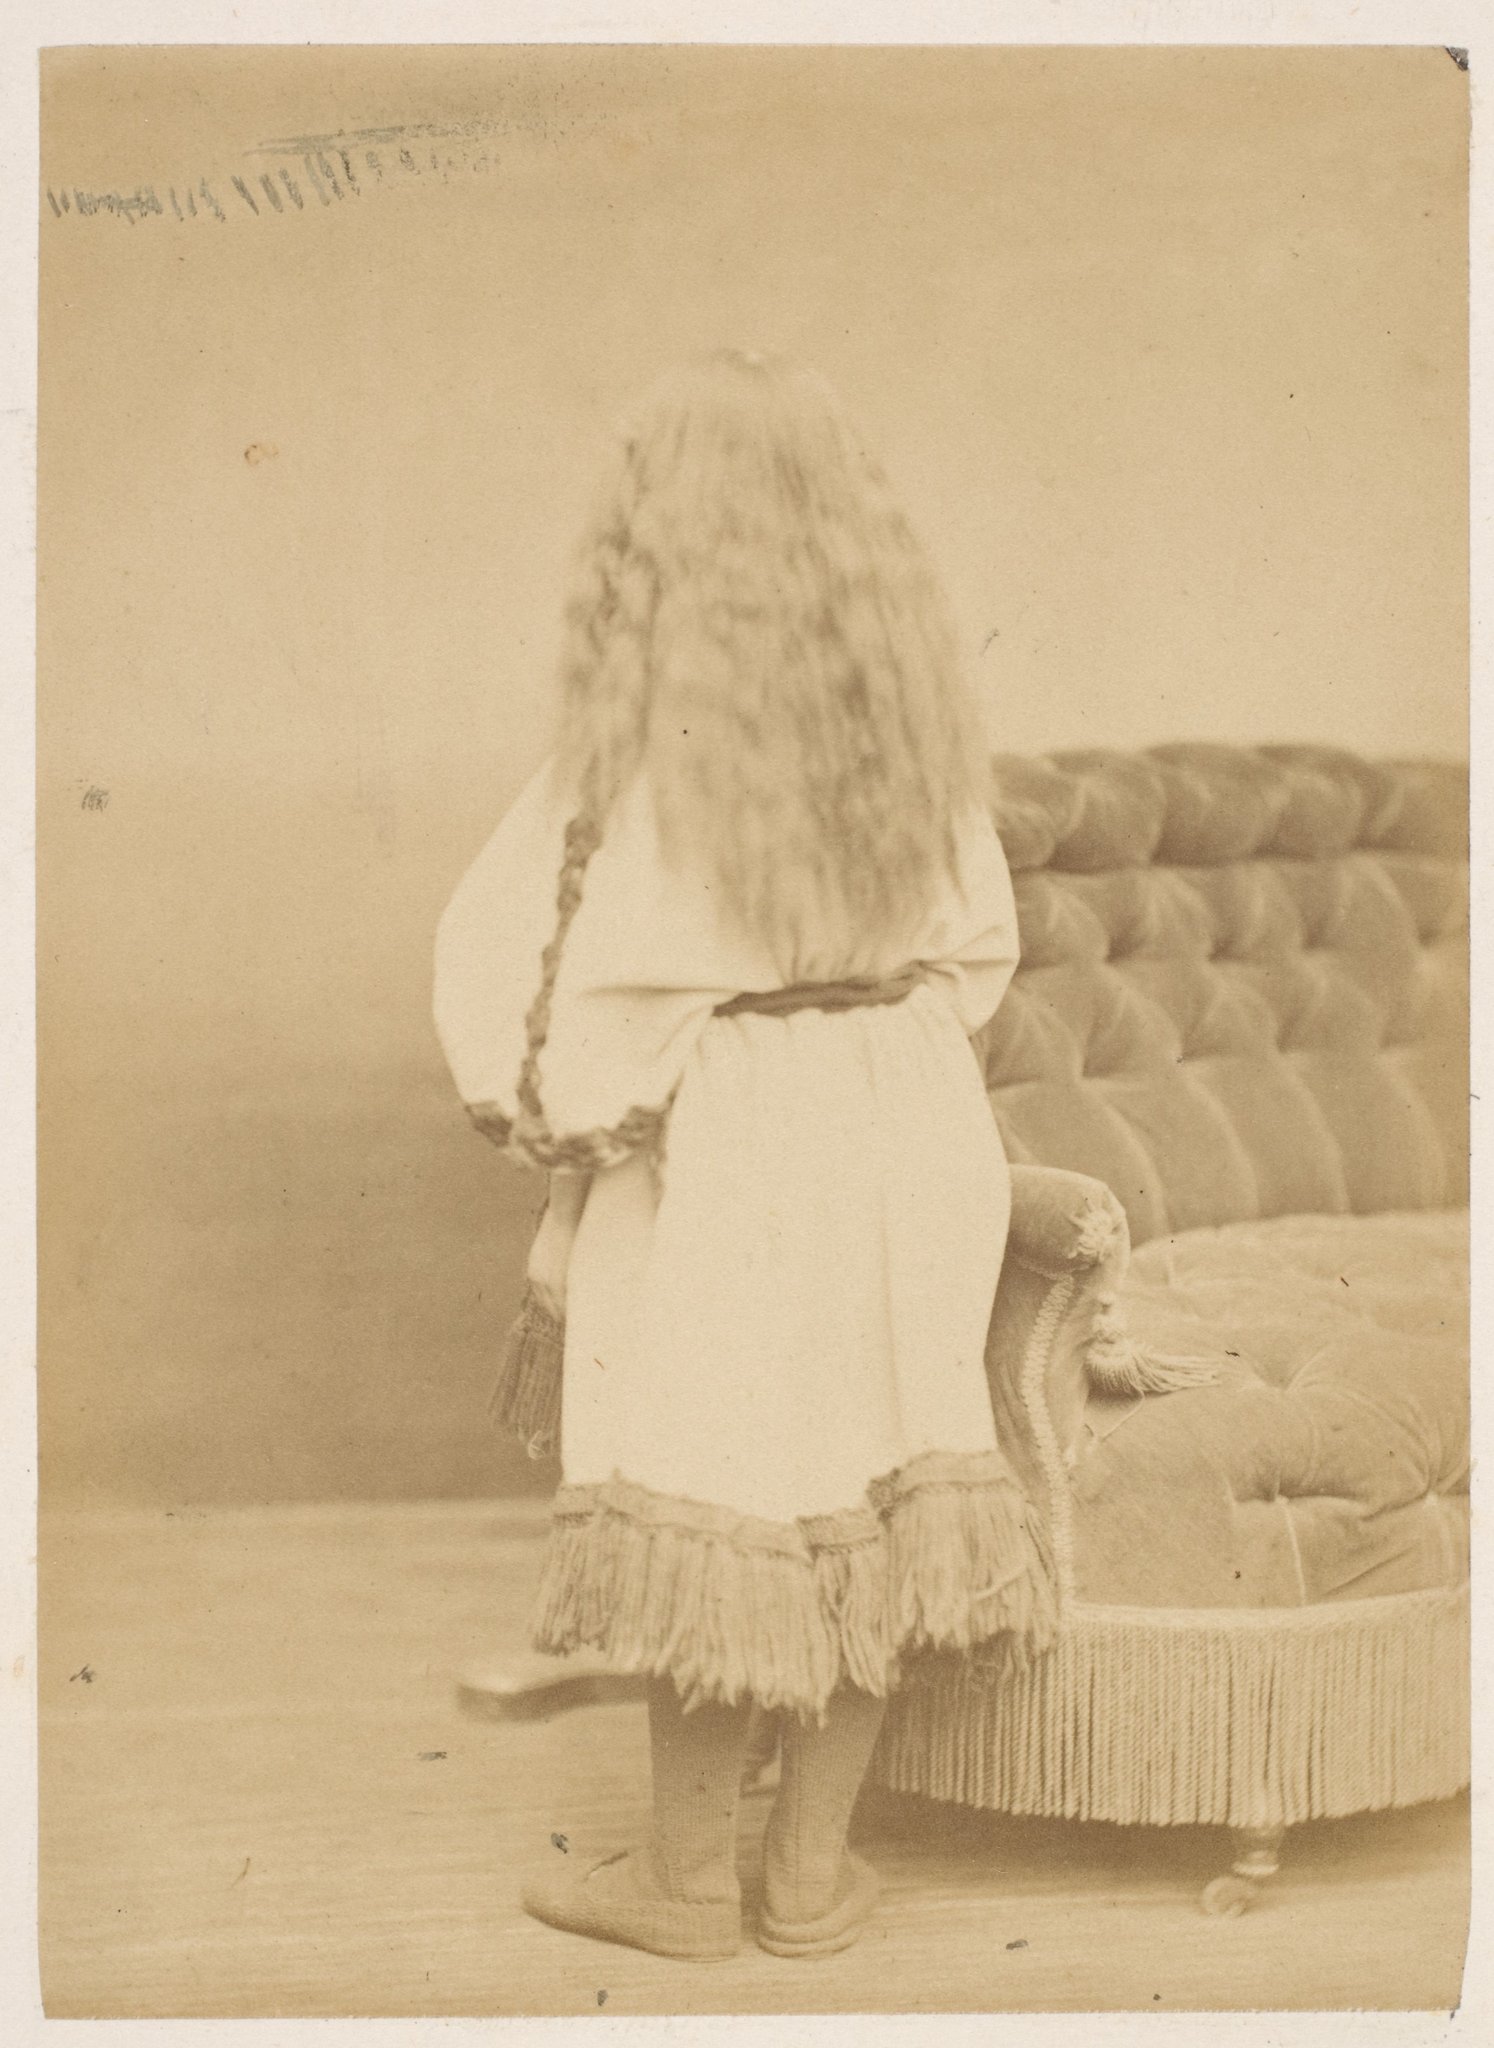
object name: photograph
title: Le chemise Russe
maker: pierre-louis pierson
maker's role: artist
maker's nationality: french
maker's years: 1822-1913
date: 1860-1869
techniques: albumen silver print, glass negative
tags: children,portraits